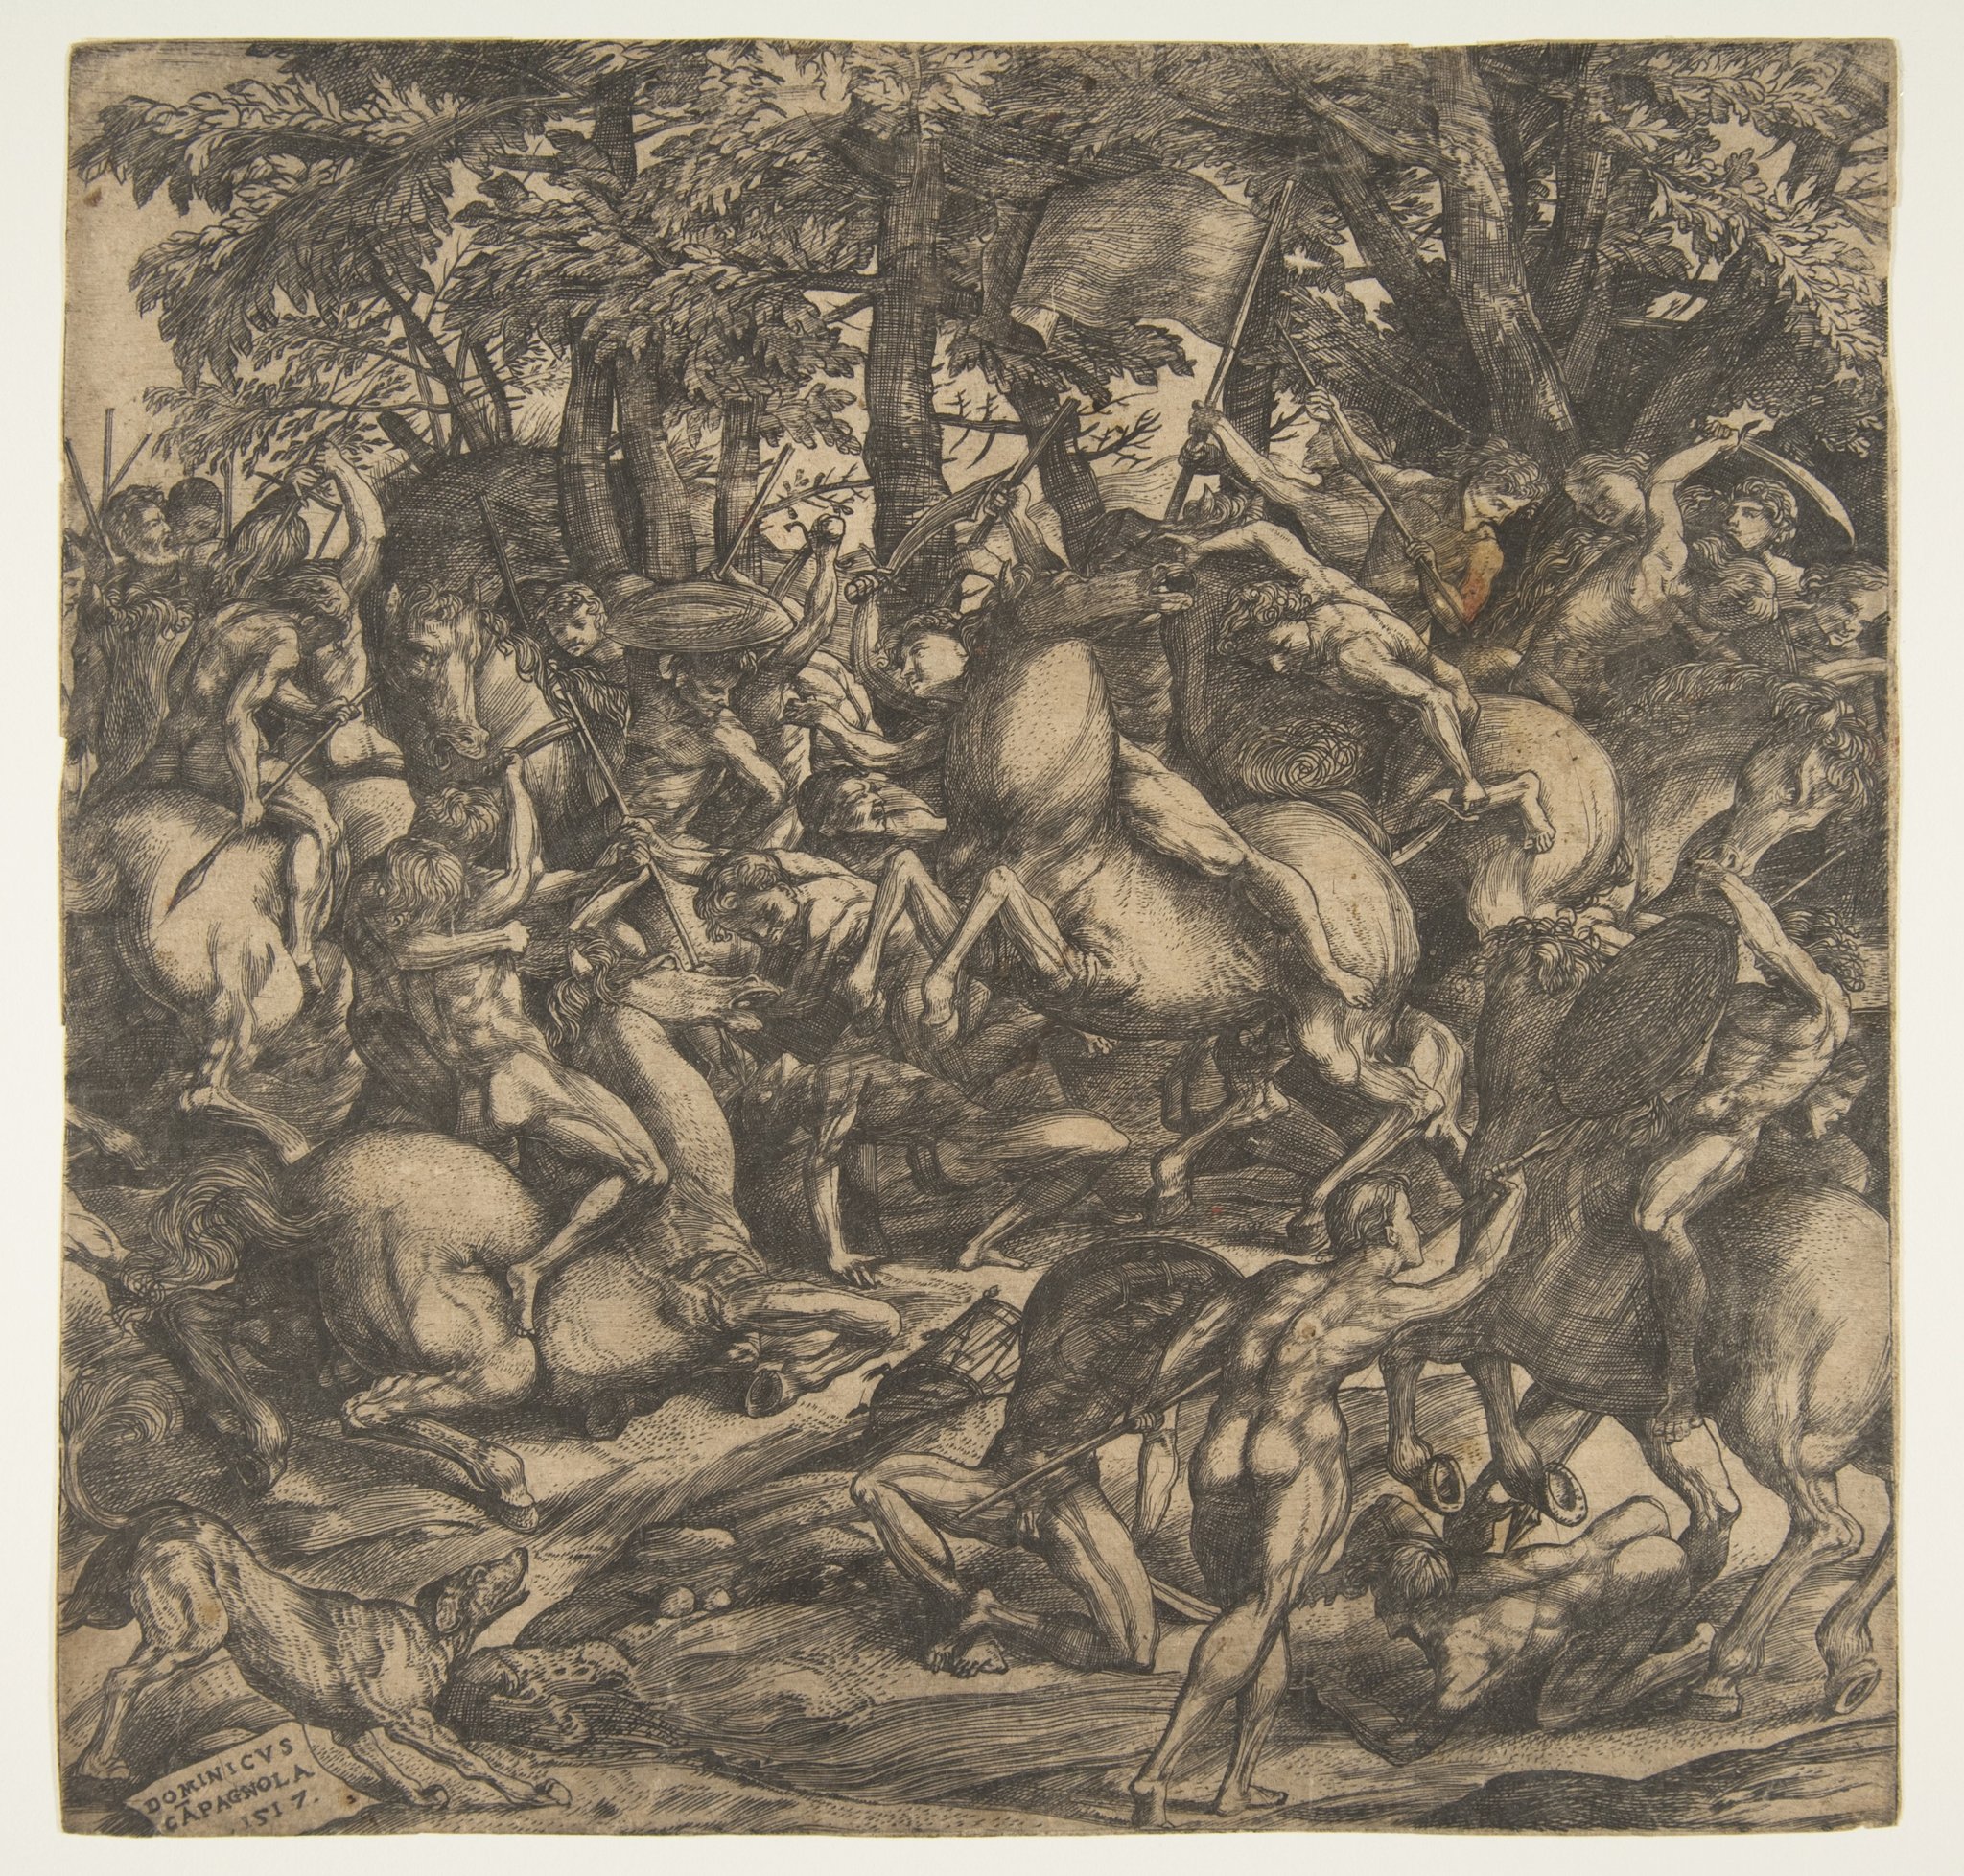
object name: print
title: Group of naked men engaged in battle in a wooded landscape, some on horseback; a dog at lower left.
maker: domenico campagnola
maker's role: artist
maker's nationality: italian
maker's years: 1500-1564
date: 1517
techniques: engraving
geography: venice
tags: battles,male nudes,dogs,horses